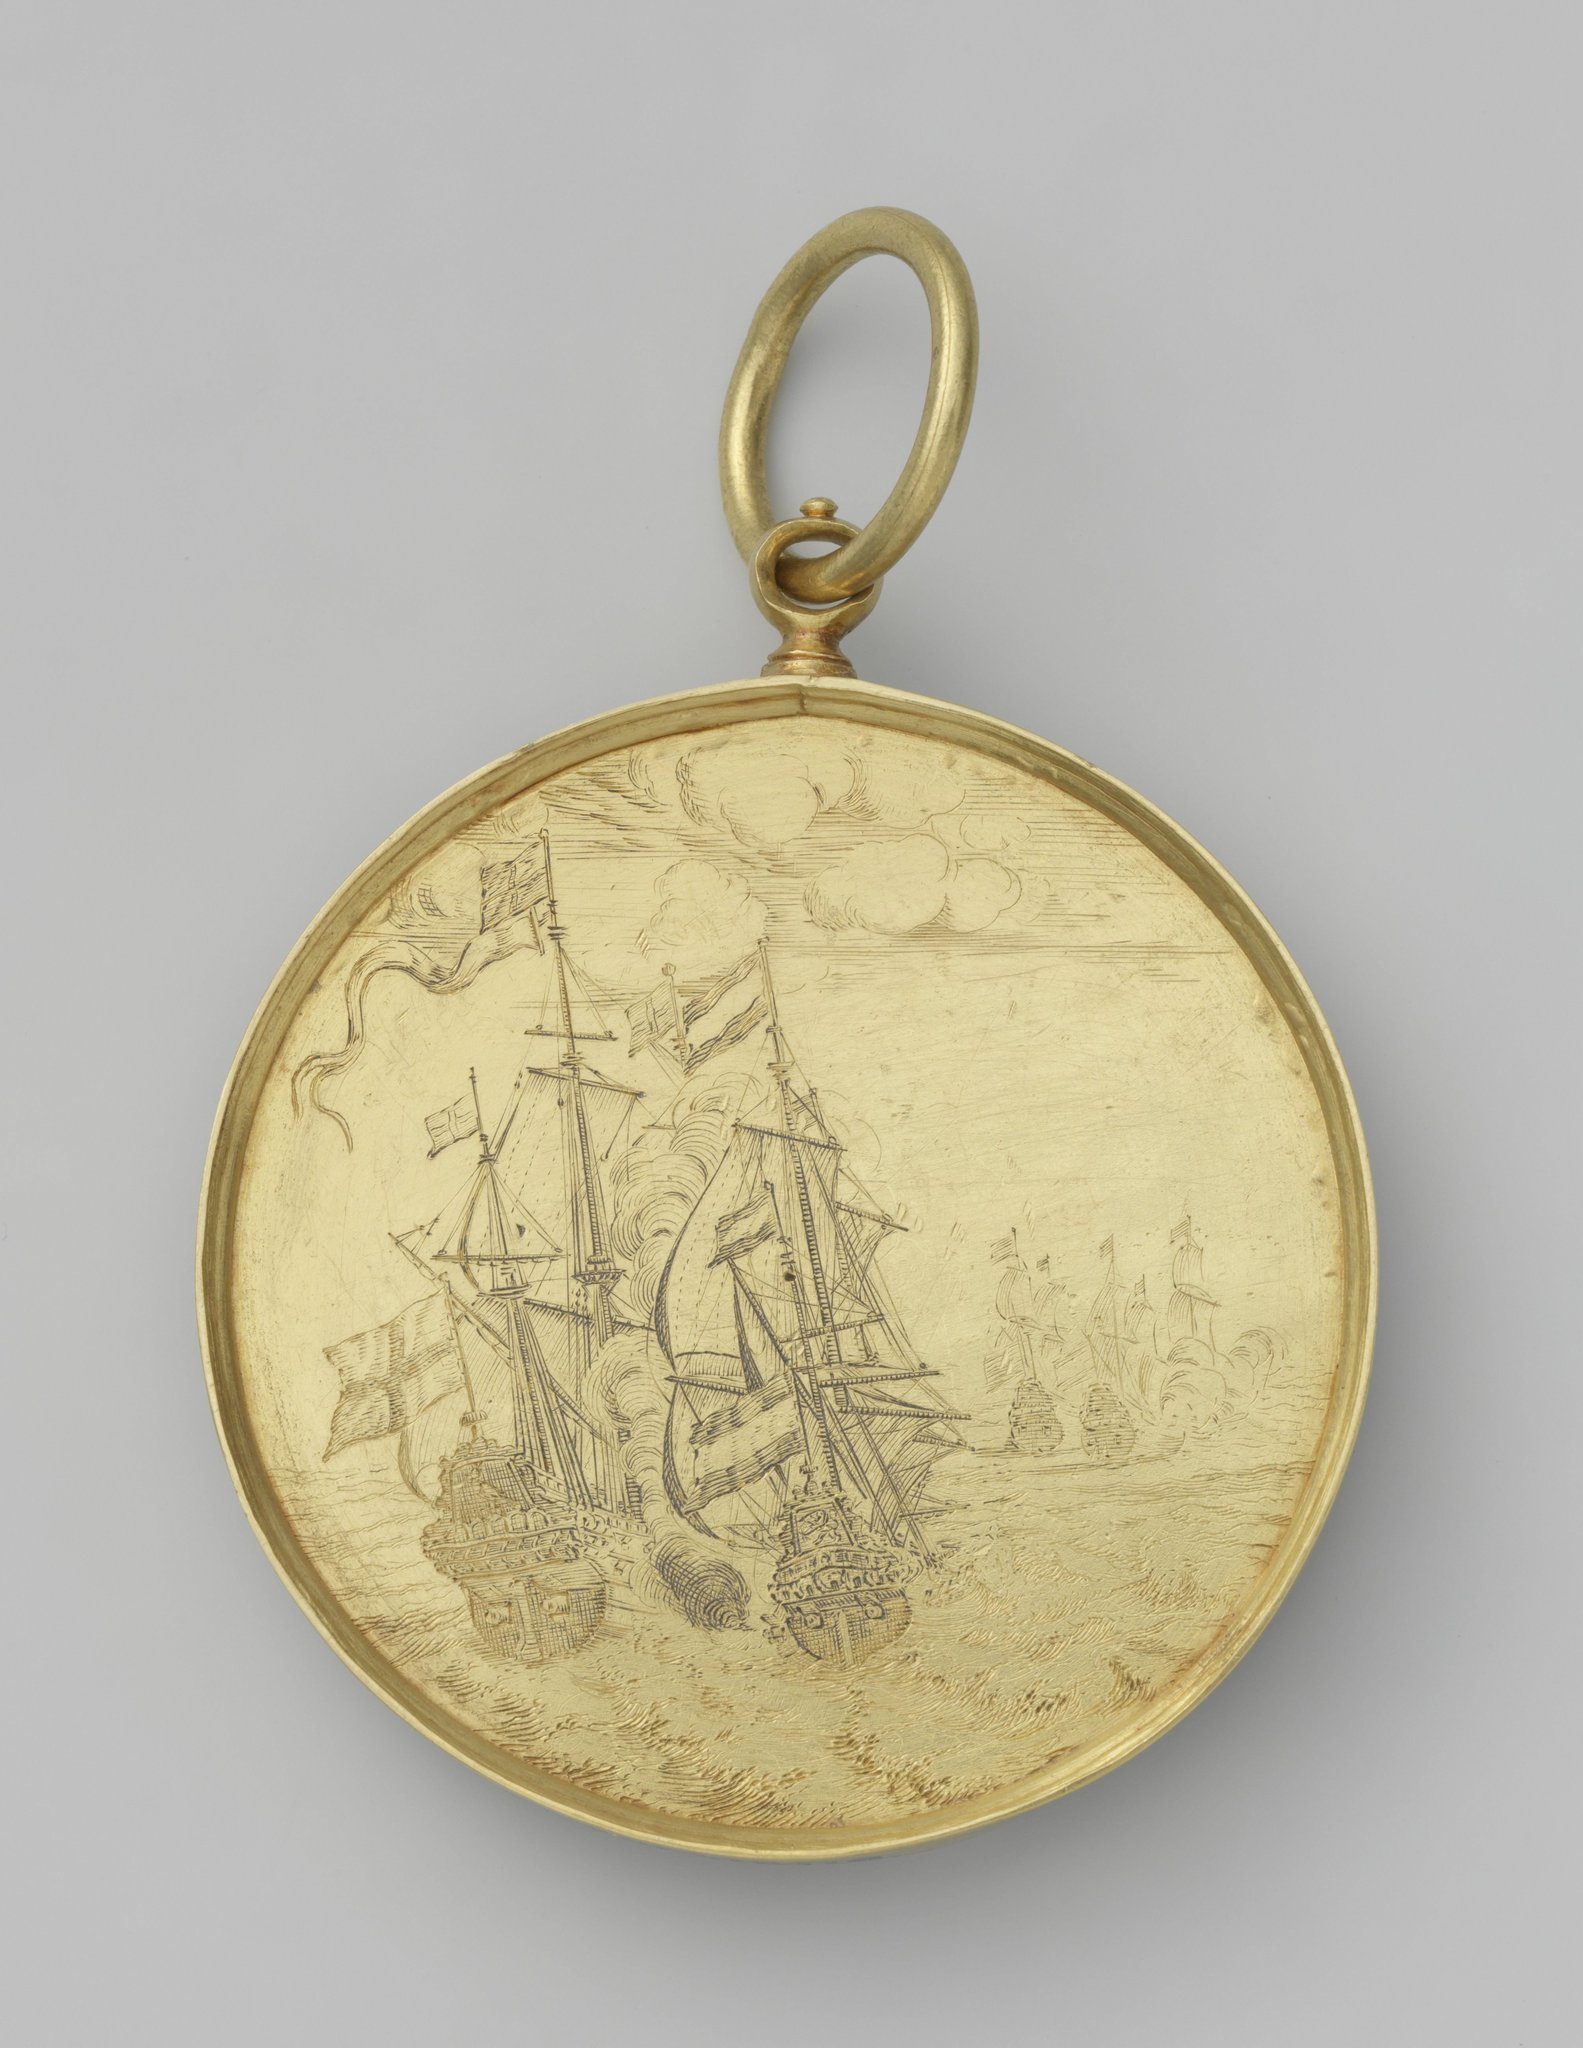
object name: history medal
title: Conquest of an English Ship by Isaac Rochussen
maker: Anonymous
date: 1672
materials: gold, silver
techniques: engraving, forging, gilding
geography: netherlands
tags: isaac rochussen, verenigde oostindische compagnie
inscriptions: date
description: People who have performed a heroic deed or reached the end of a long career are sometimes awarded a medal as a token of esteem and gratitude. Often these are made of gold. Especially in the seventeenth century, gold medals with their chains were literally a reward. They were subsequently melted down and converted into money, which is why so few have survived.